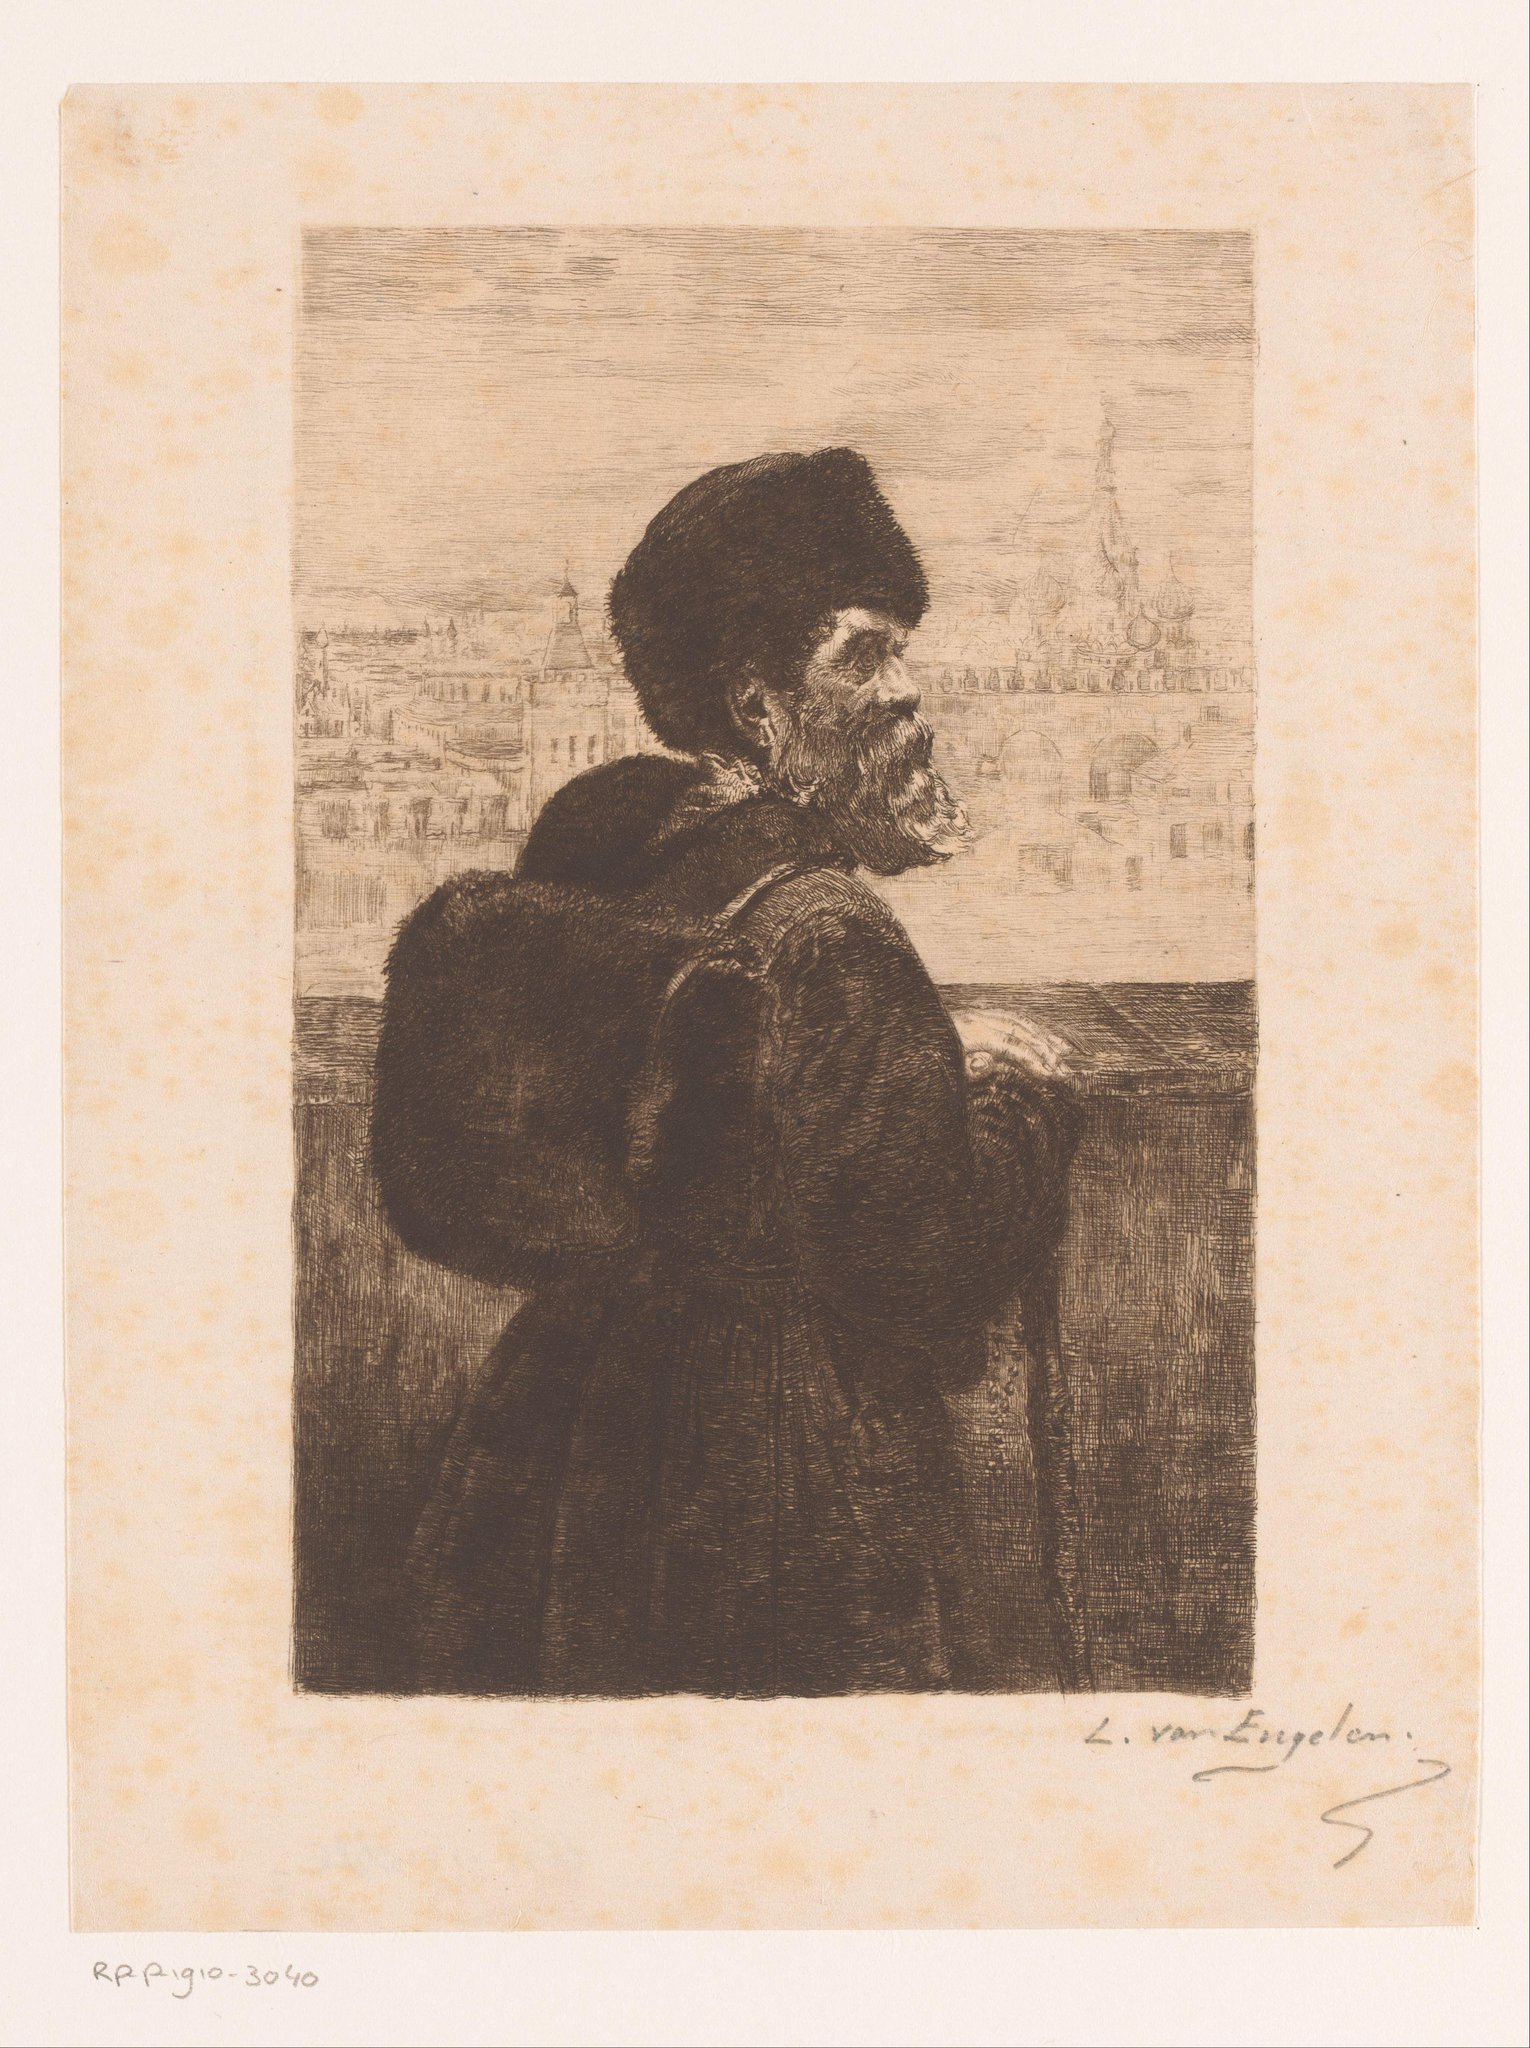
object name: print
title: Russische man met wandelstok en Moskou op de achtergrond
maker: louis van engelen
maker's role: print maker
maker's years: 1856-1940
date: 1866-1910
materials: paper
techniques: etching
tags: city-view, and landscape with man-made constructions, adult man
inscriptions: mark: ‘Antwerpsche Etsers 1880’, collector's mark: Lugt 2228